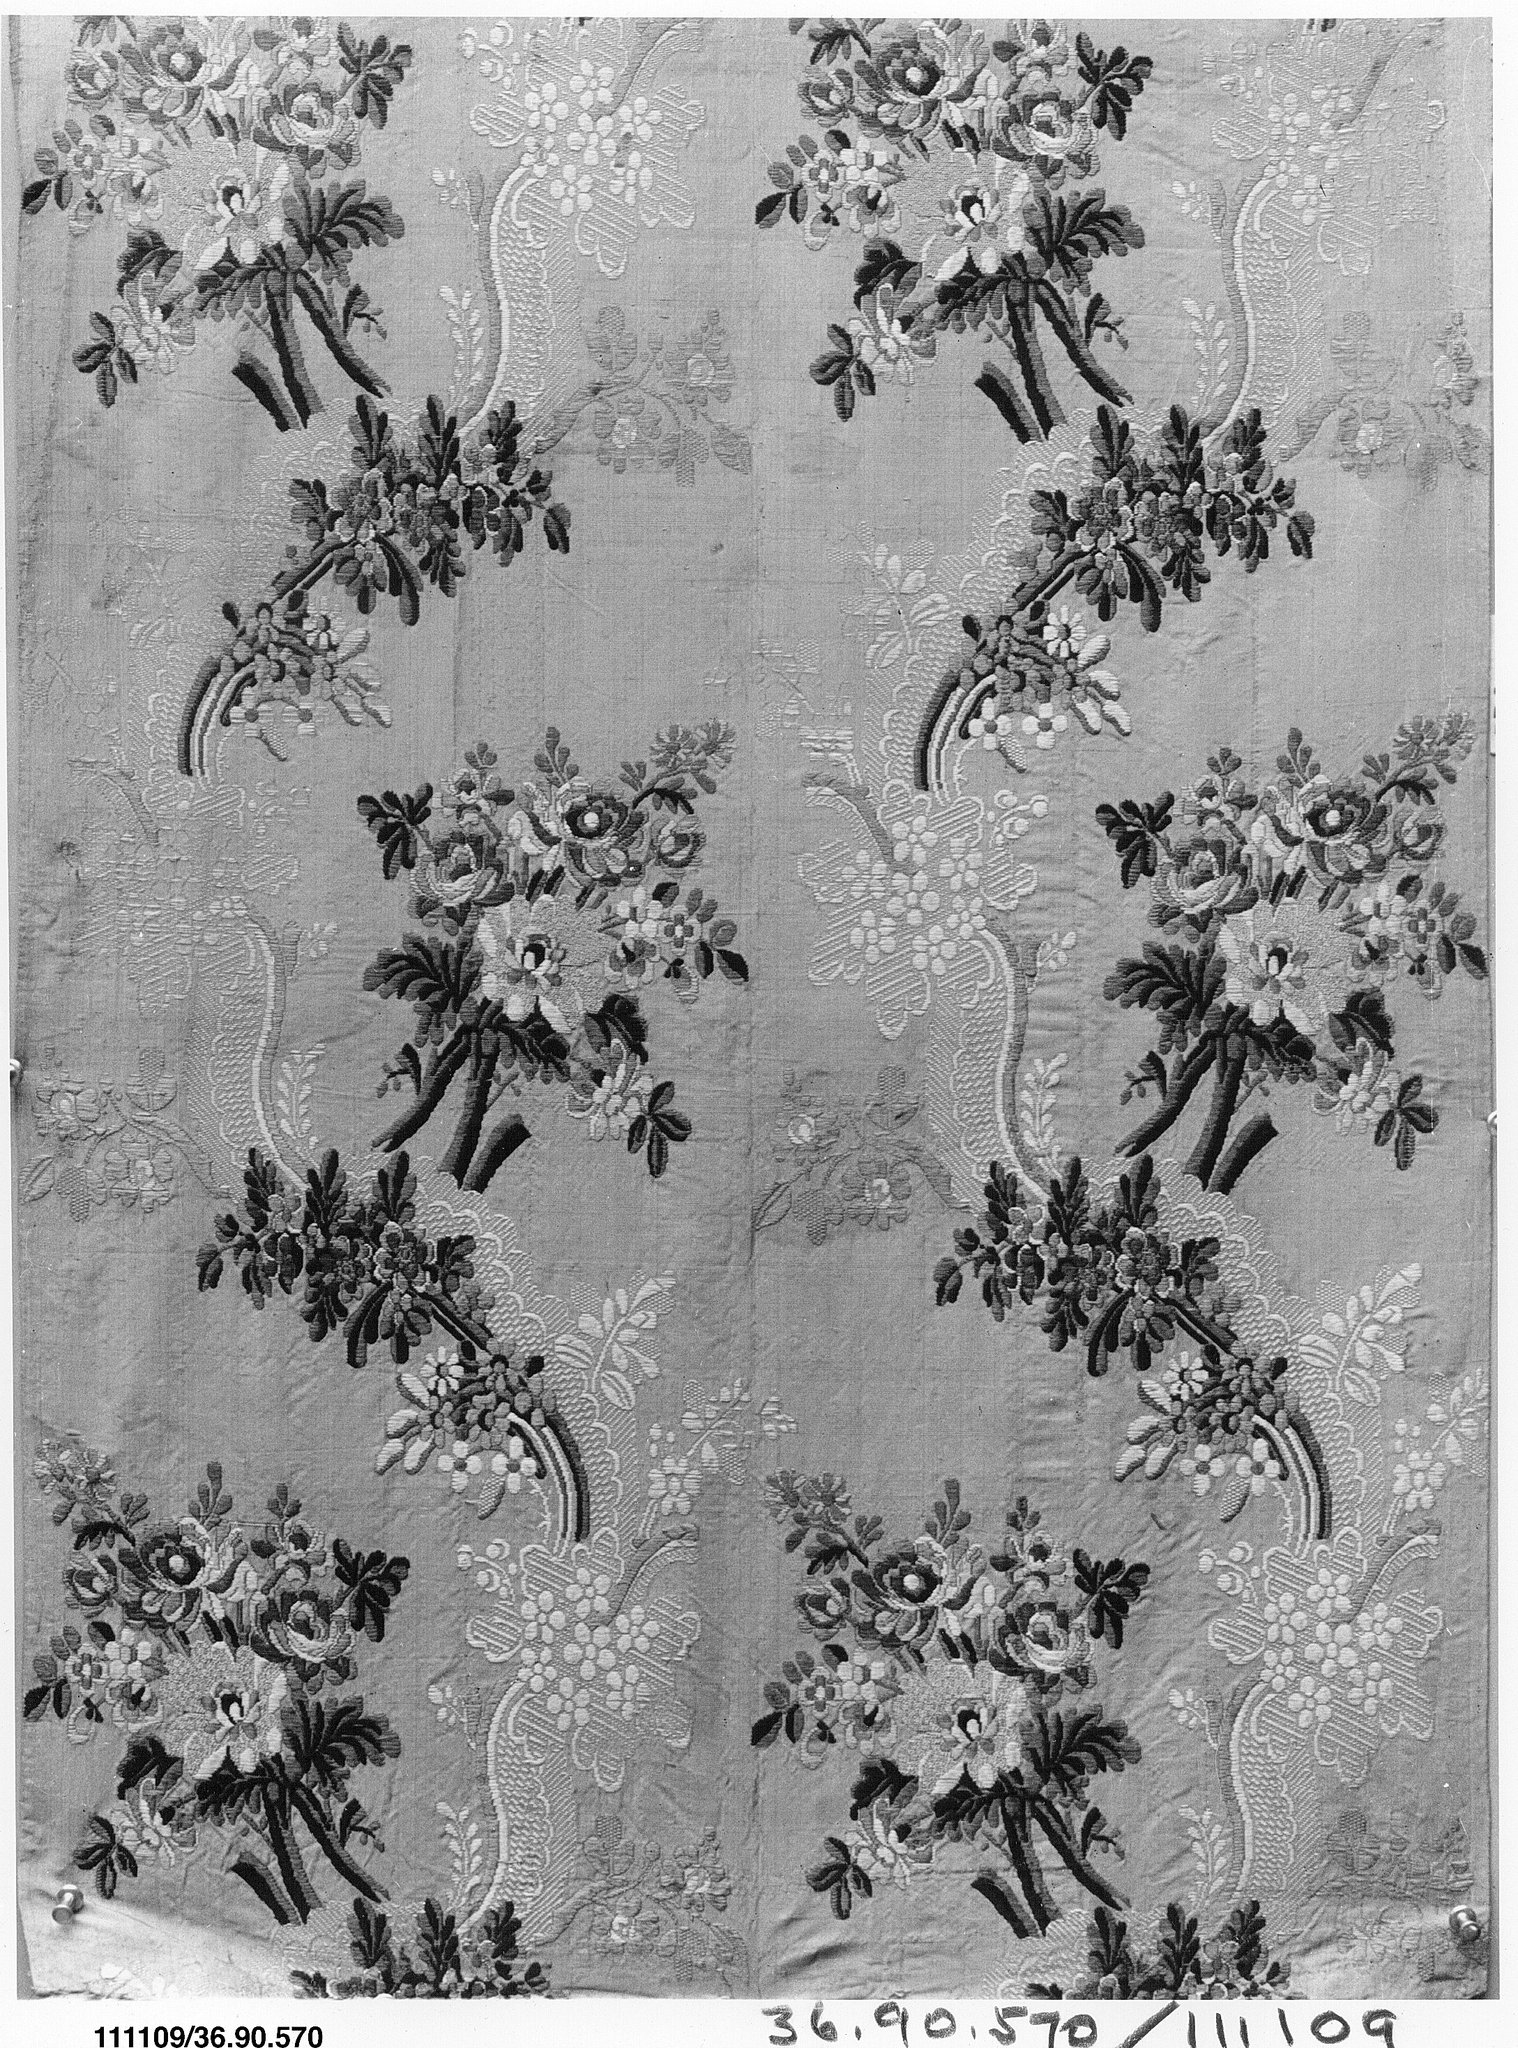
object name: piece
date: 1760-1770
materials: silk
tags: flowers